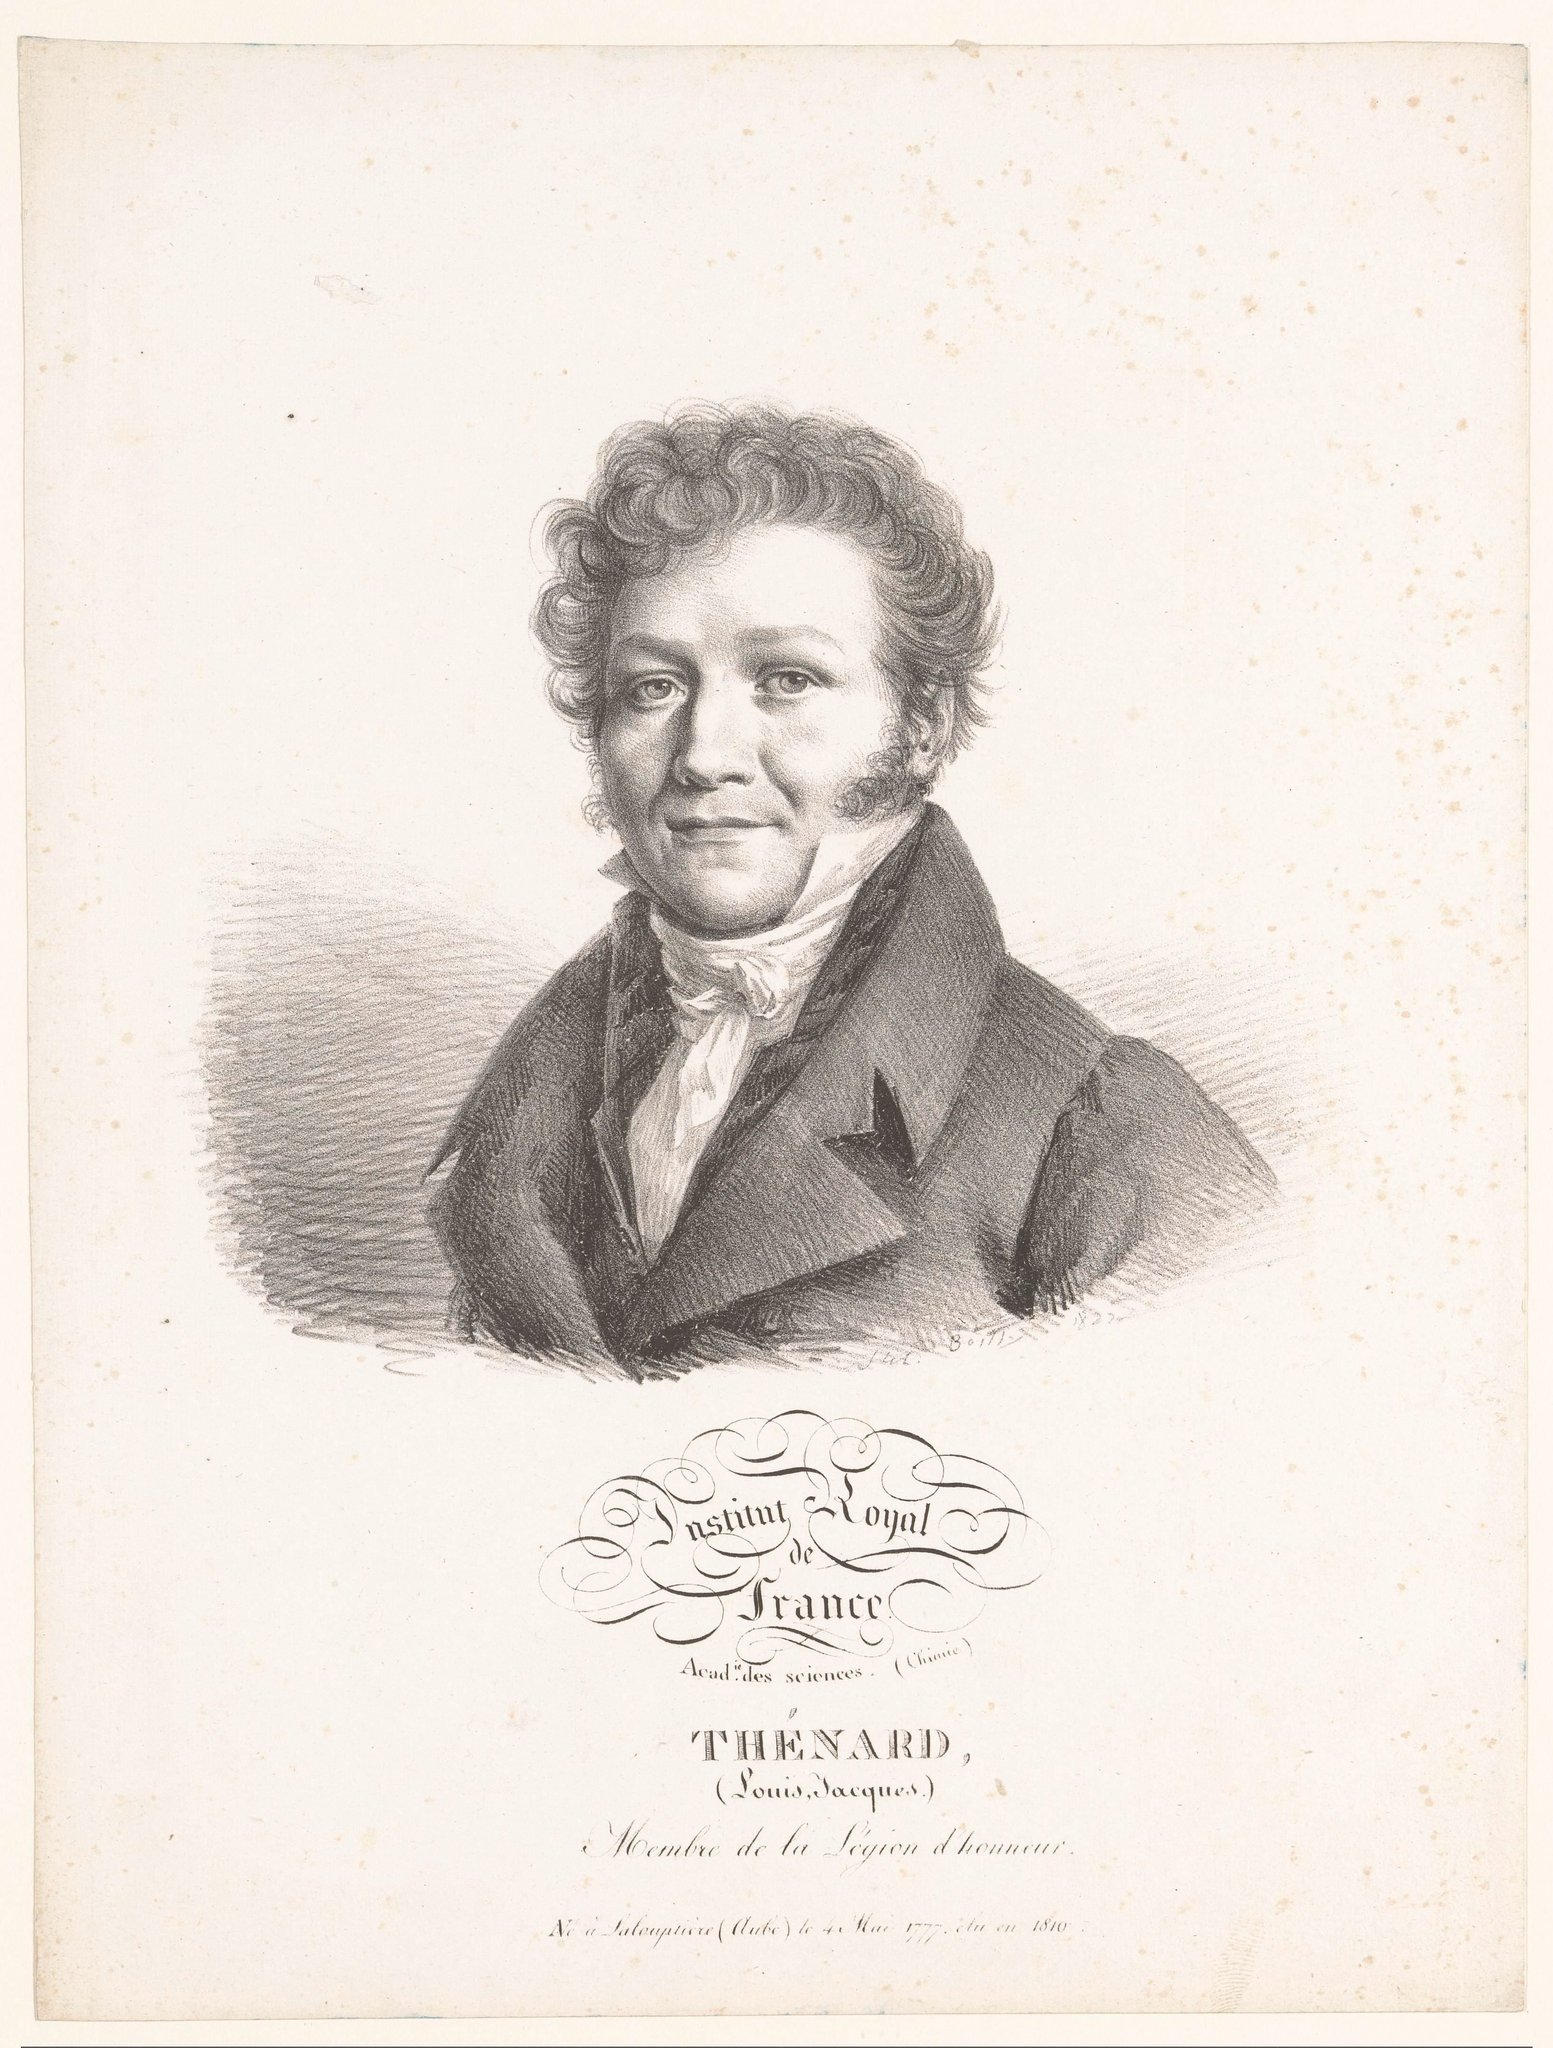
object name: print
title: Leden van het Institut Royal de France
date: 1822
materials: paper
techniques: lithograph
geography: paris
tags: paris, historical persons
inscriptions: collector's mark: Lugt 2228a